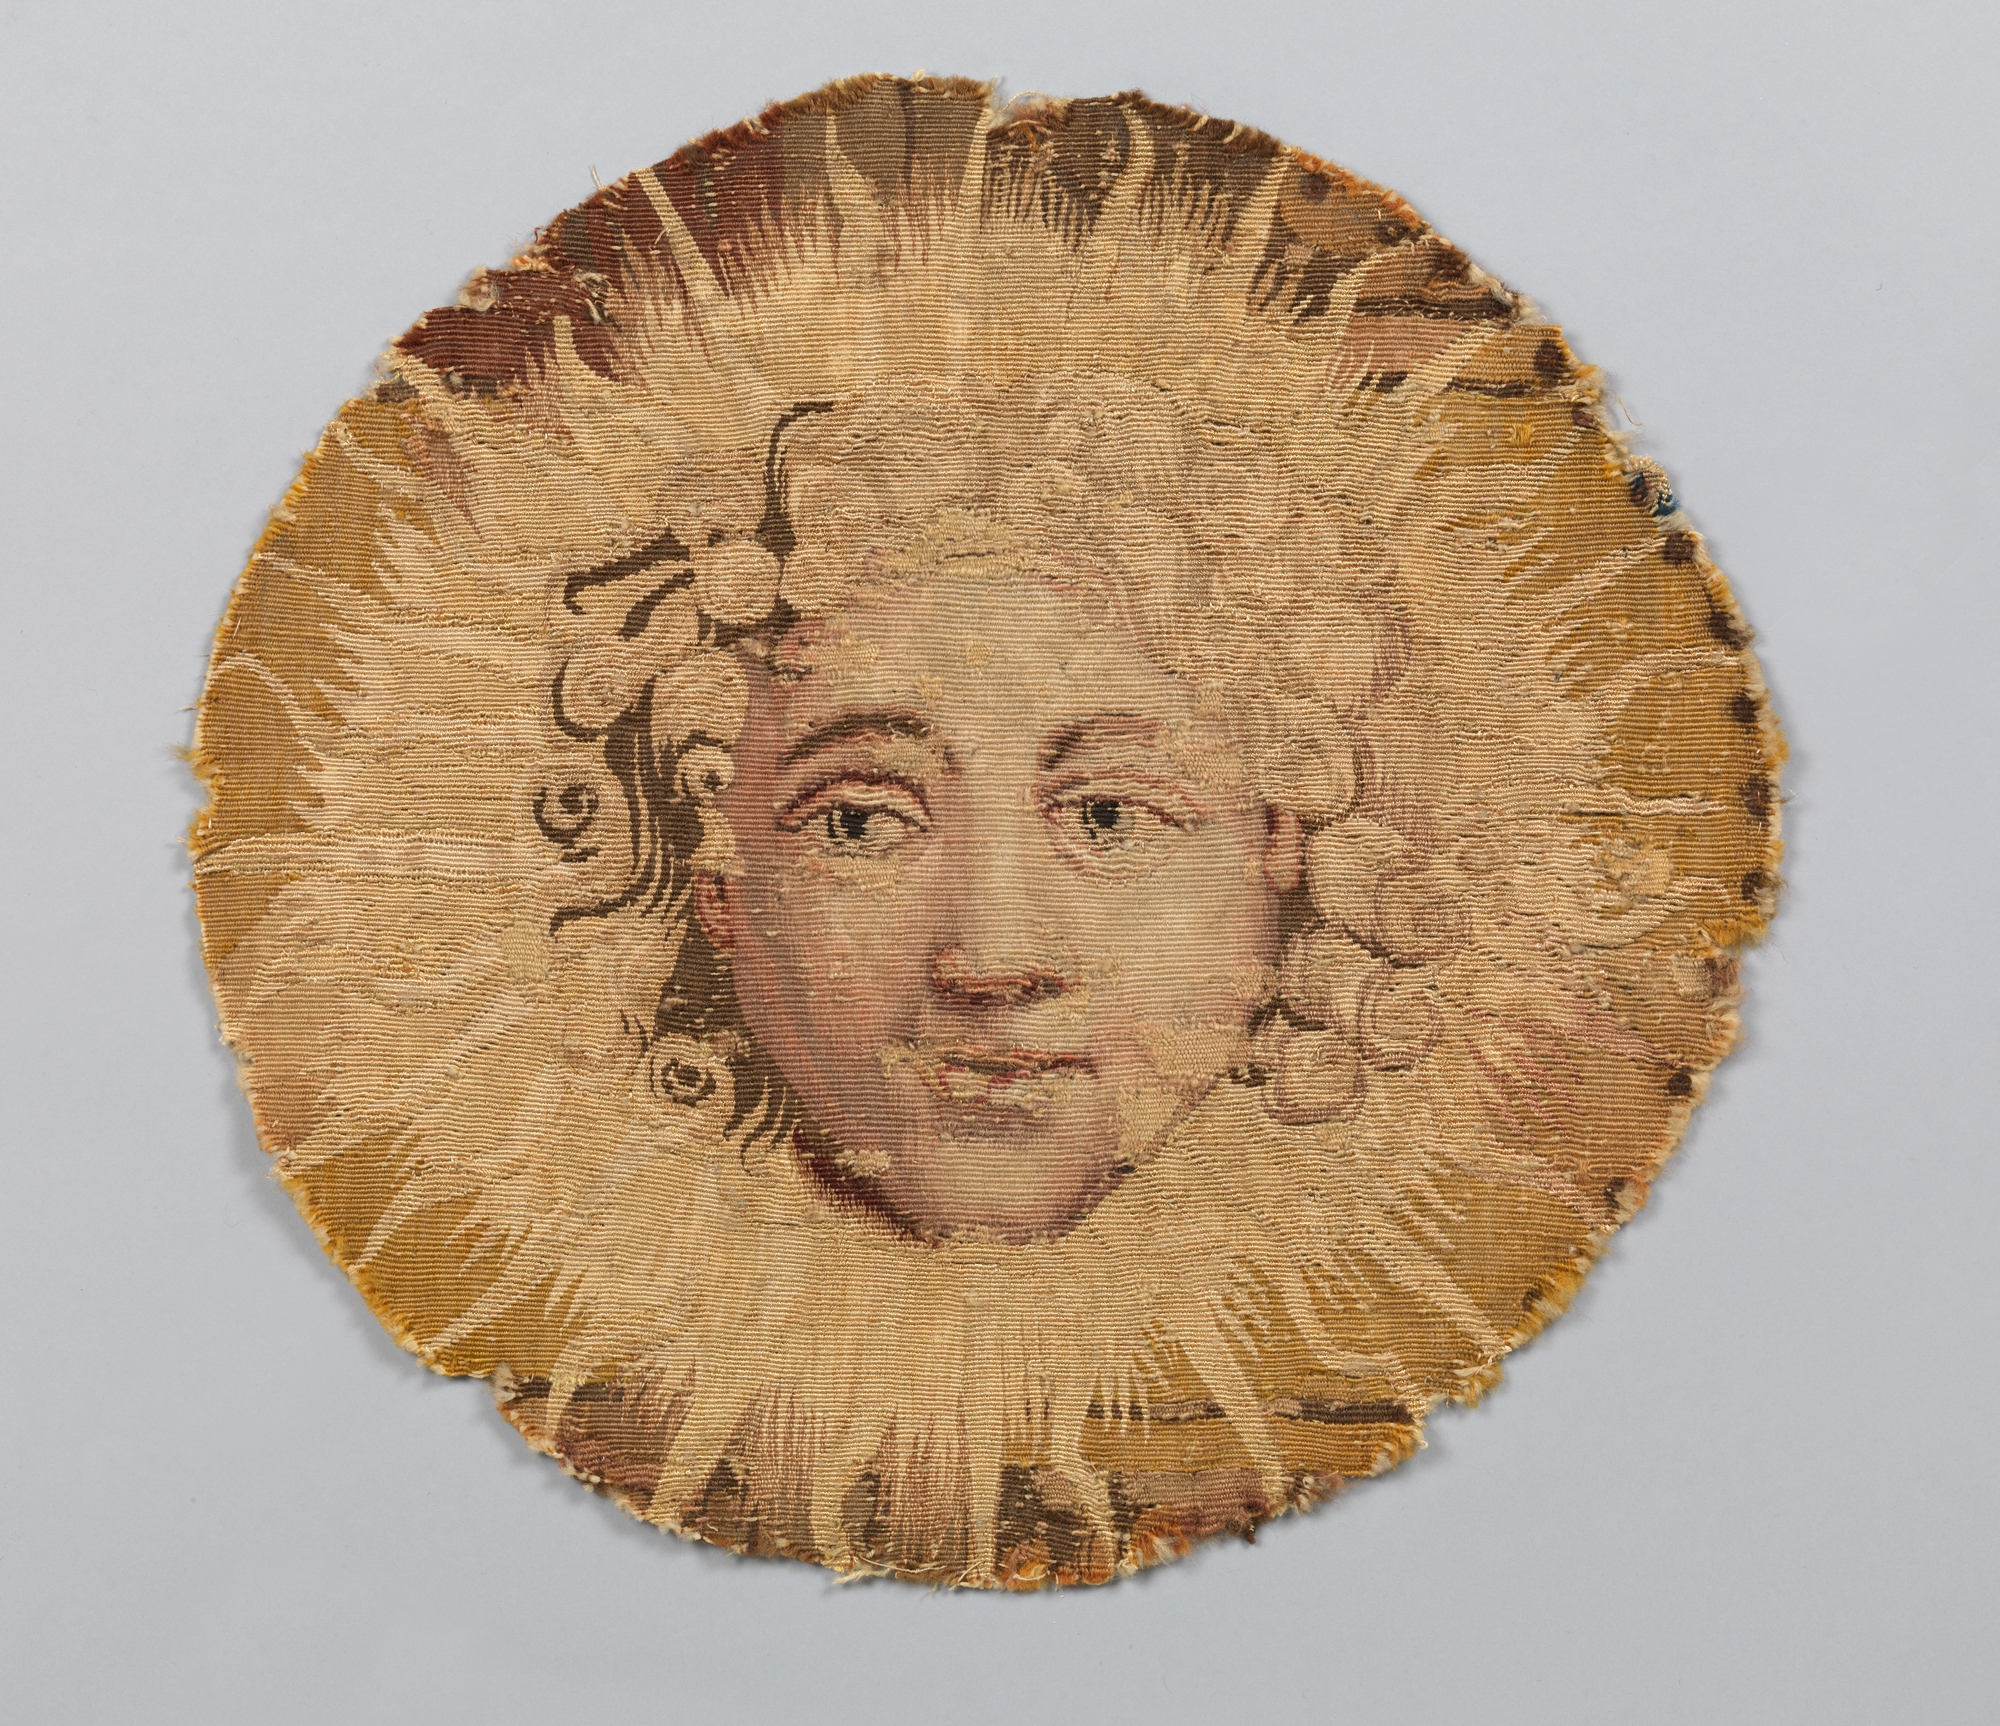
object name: tapestry fragment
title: Head of Apollo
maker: manufacture nationale des gobelins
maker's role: manufactory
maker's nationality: french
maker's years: 1662-1799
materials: silk, wool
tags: heads,apollo